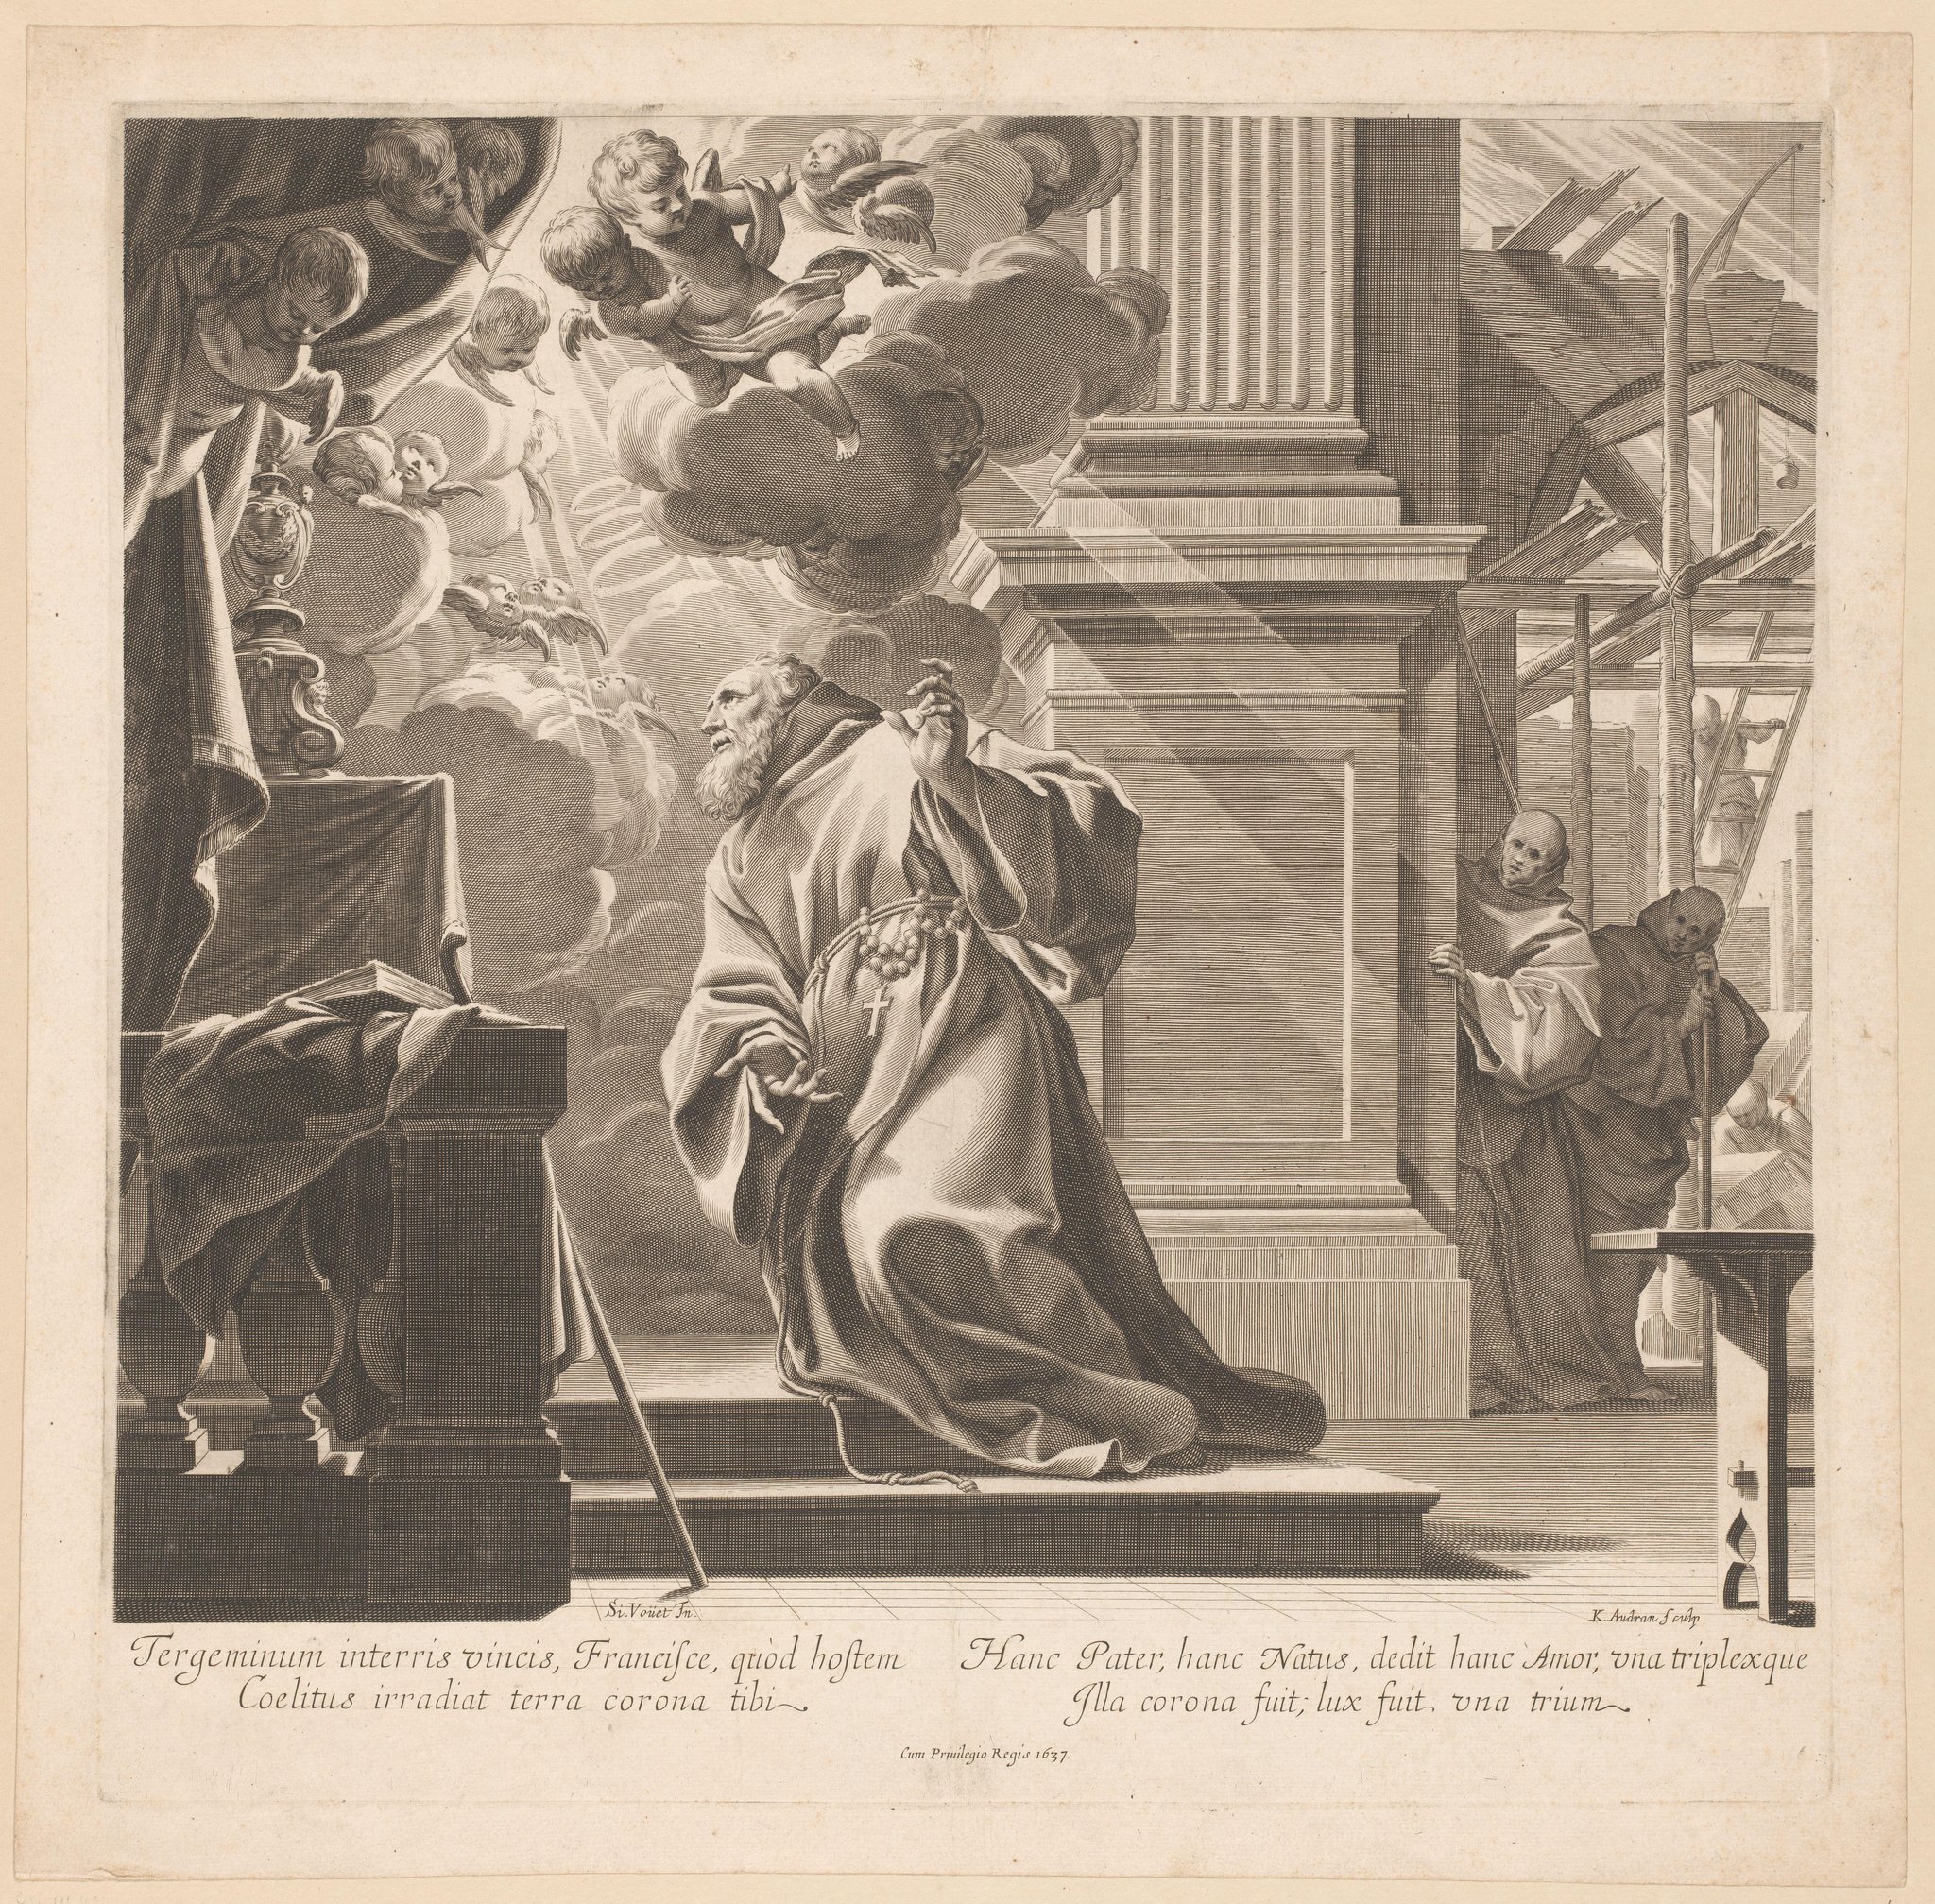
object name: print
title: H. Franciscus in extase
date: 1637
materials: paper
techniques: engraving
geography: france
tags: building-site of church indicated by a miracle, st. francis of assisi in ecstasy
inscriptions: collector's mark: Lugt 240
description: Franciscus zit geknield voor een altaar in wat een bouwvallige kerk lijkt te zijn. Drie kronen dalen in een lichtstraal op hem neer, terwijl engelen gezeten op wolken verschijnen aan het altaar. Op de achtergrond twee monniken die het werk gestaakt zijn en toekijken naar het tafereel.